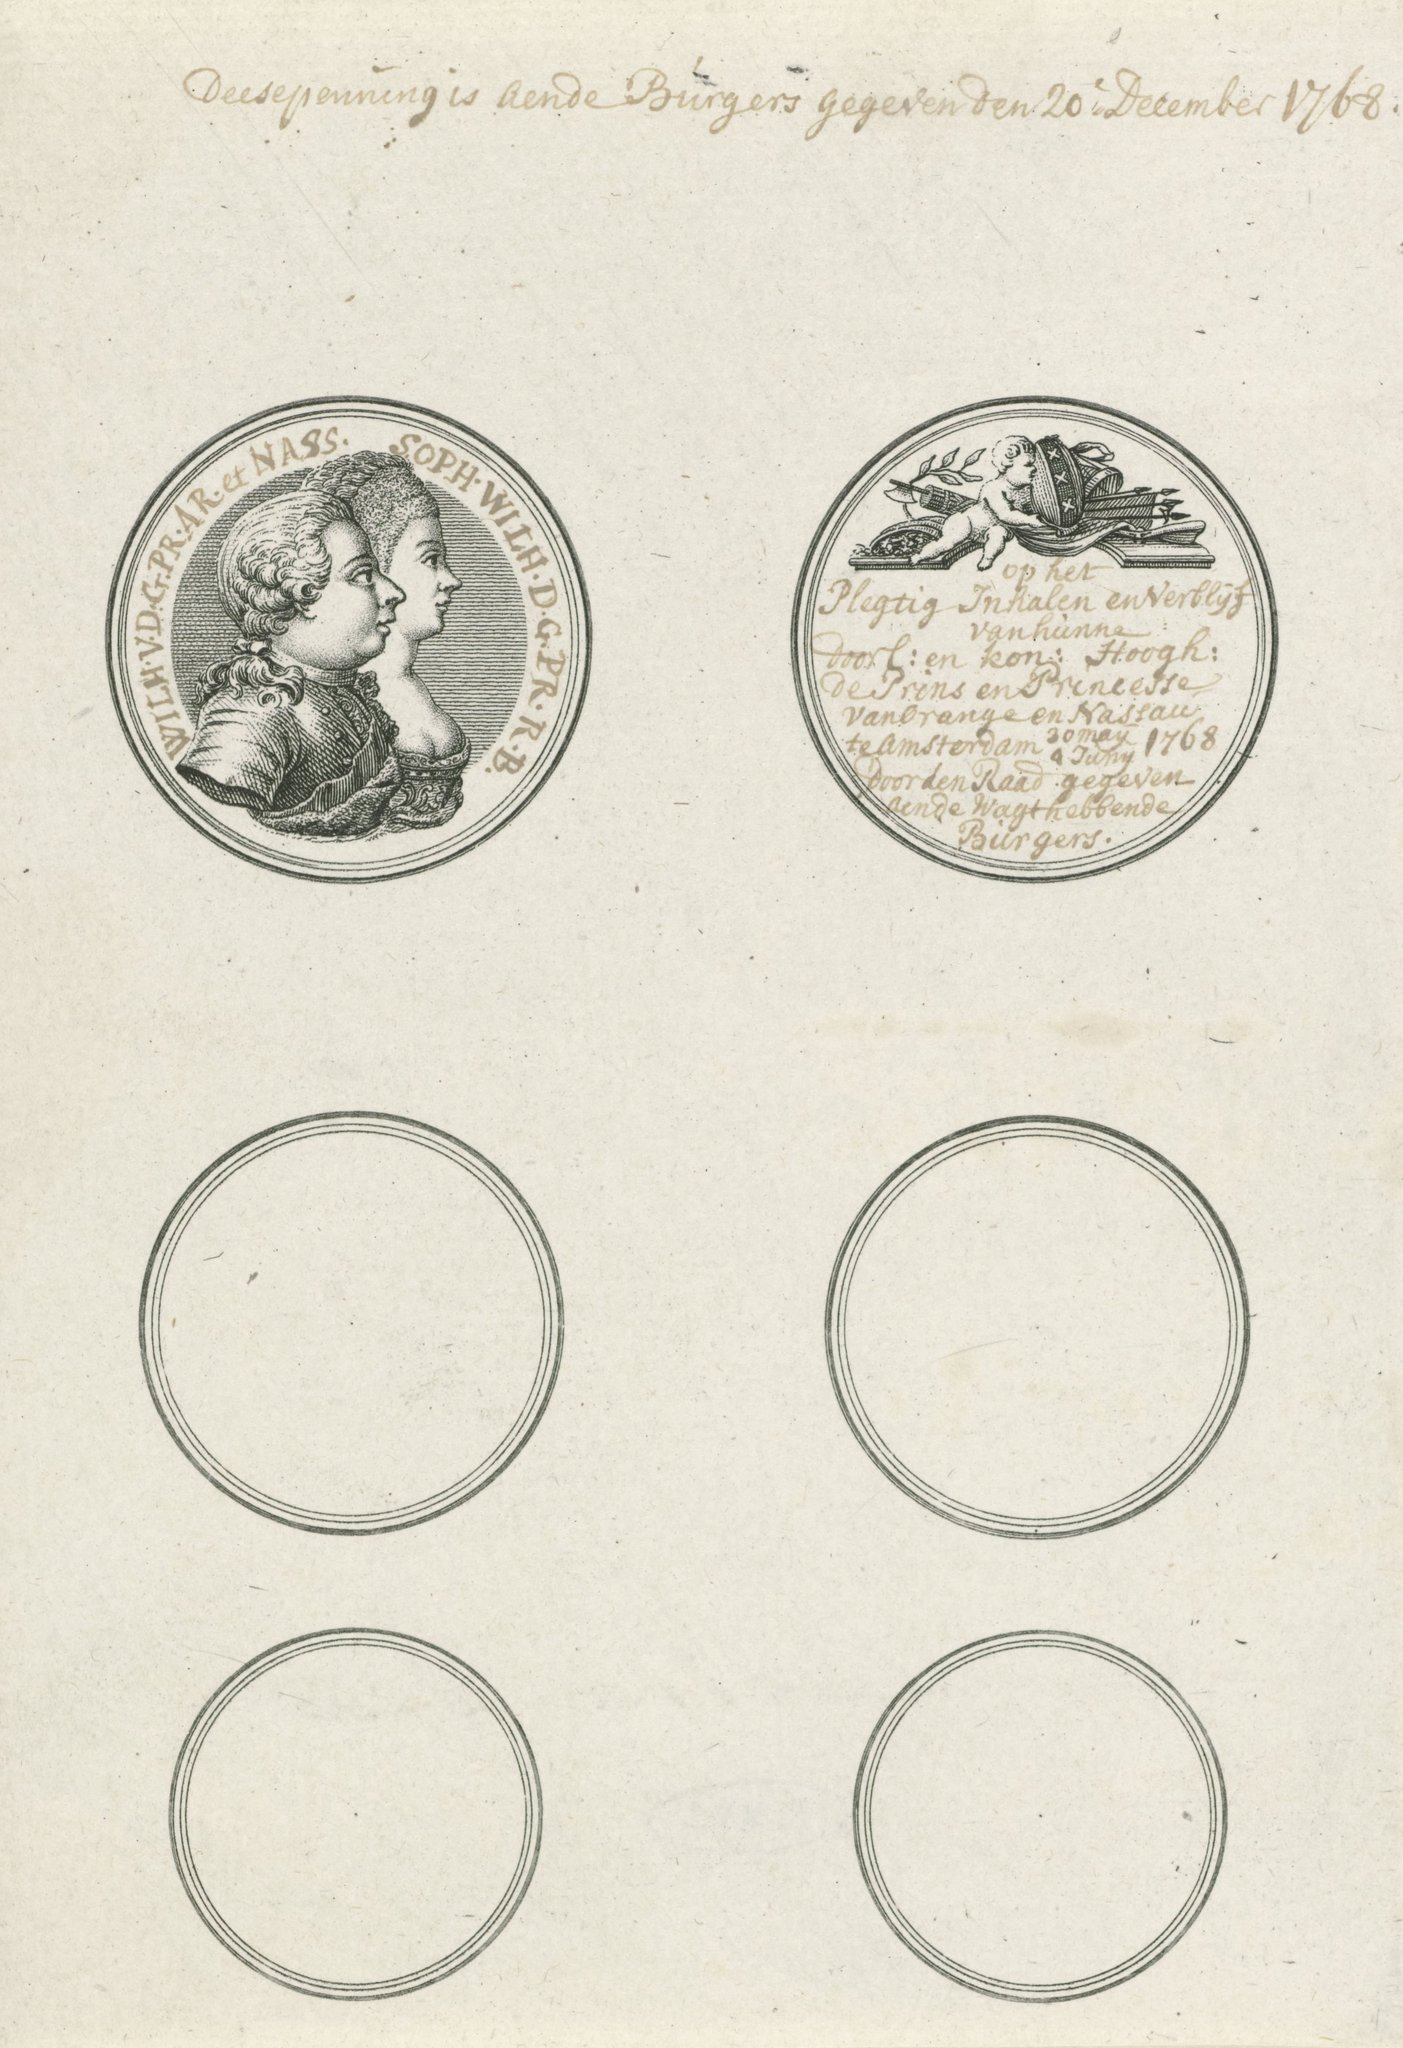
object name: print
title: Gedenkpenning ter ere van het bezoek van Willem V en Wilhelmina van Pruisen te Amsterdam, 1768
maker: Anonymous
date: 1768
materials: paper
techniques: etching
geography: northern netherlands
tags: the hague, william v (prince of orange), berlin, draughtsman, wilhelmina of prussia (princess of orange), medal (considered as a piece of sculpture, regardless of its specific function), amsterdam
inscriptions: collector's mark: Lugt 2228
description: De gedenkpenning geslagen door de Amsterdamse Raad en uitgedeeld aan de wachthebbende burgers op 20 december 1768, ter ere van het bezoek van Willem V en Wilhelmina van Pruisen aan Amsterdam, 31 mei - 4 juni 1768. Van de penning zijn bovenaan de voor- en keerzijde afgebeeld, daaronder dezelfde penning in twee kleinere formaten, alleen in omtrek. Met handgeschreven opschriften in de penning.